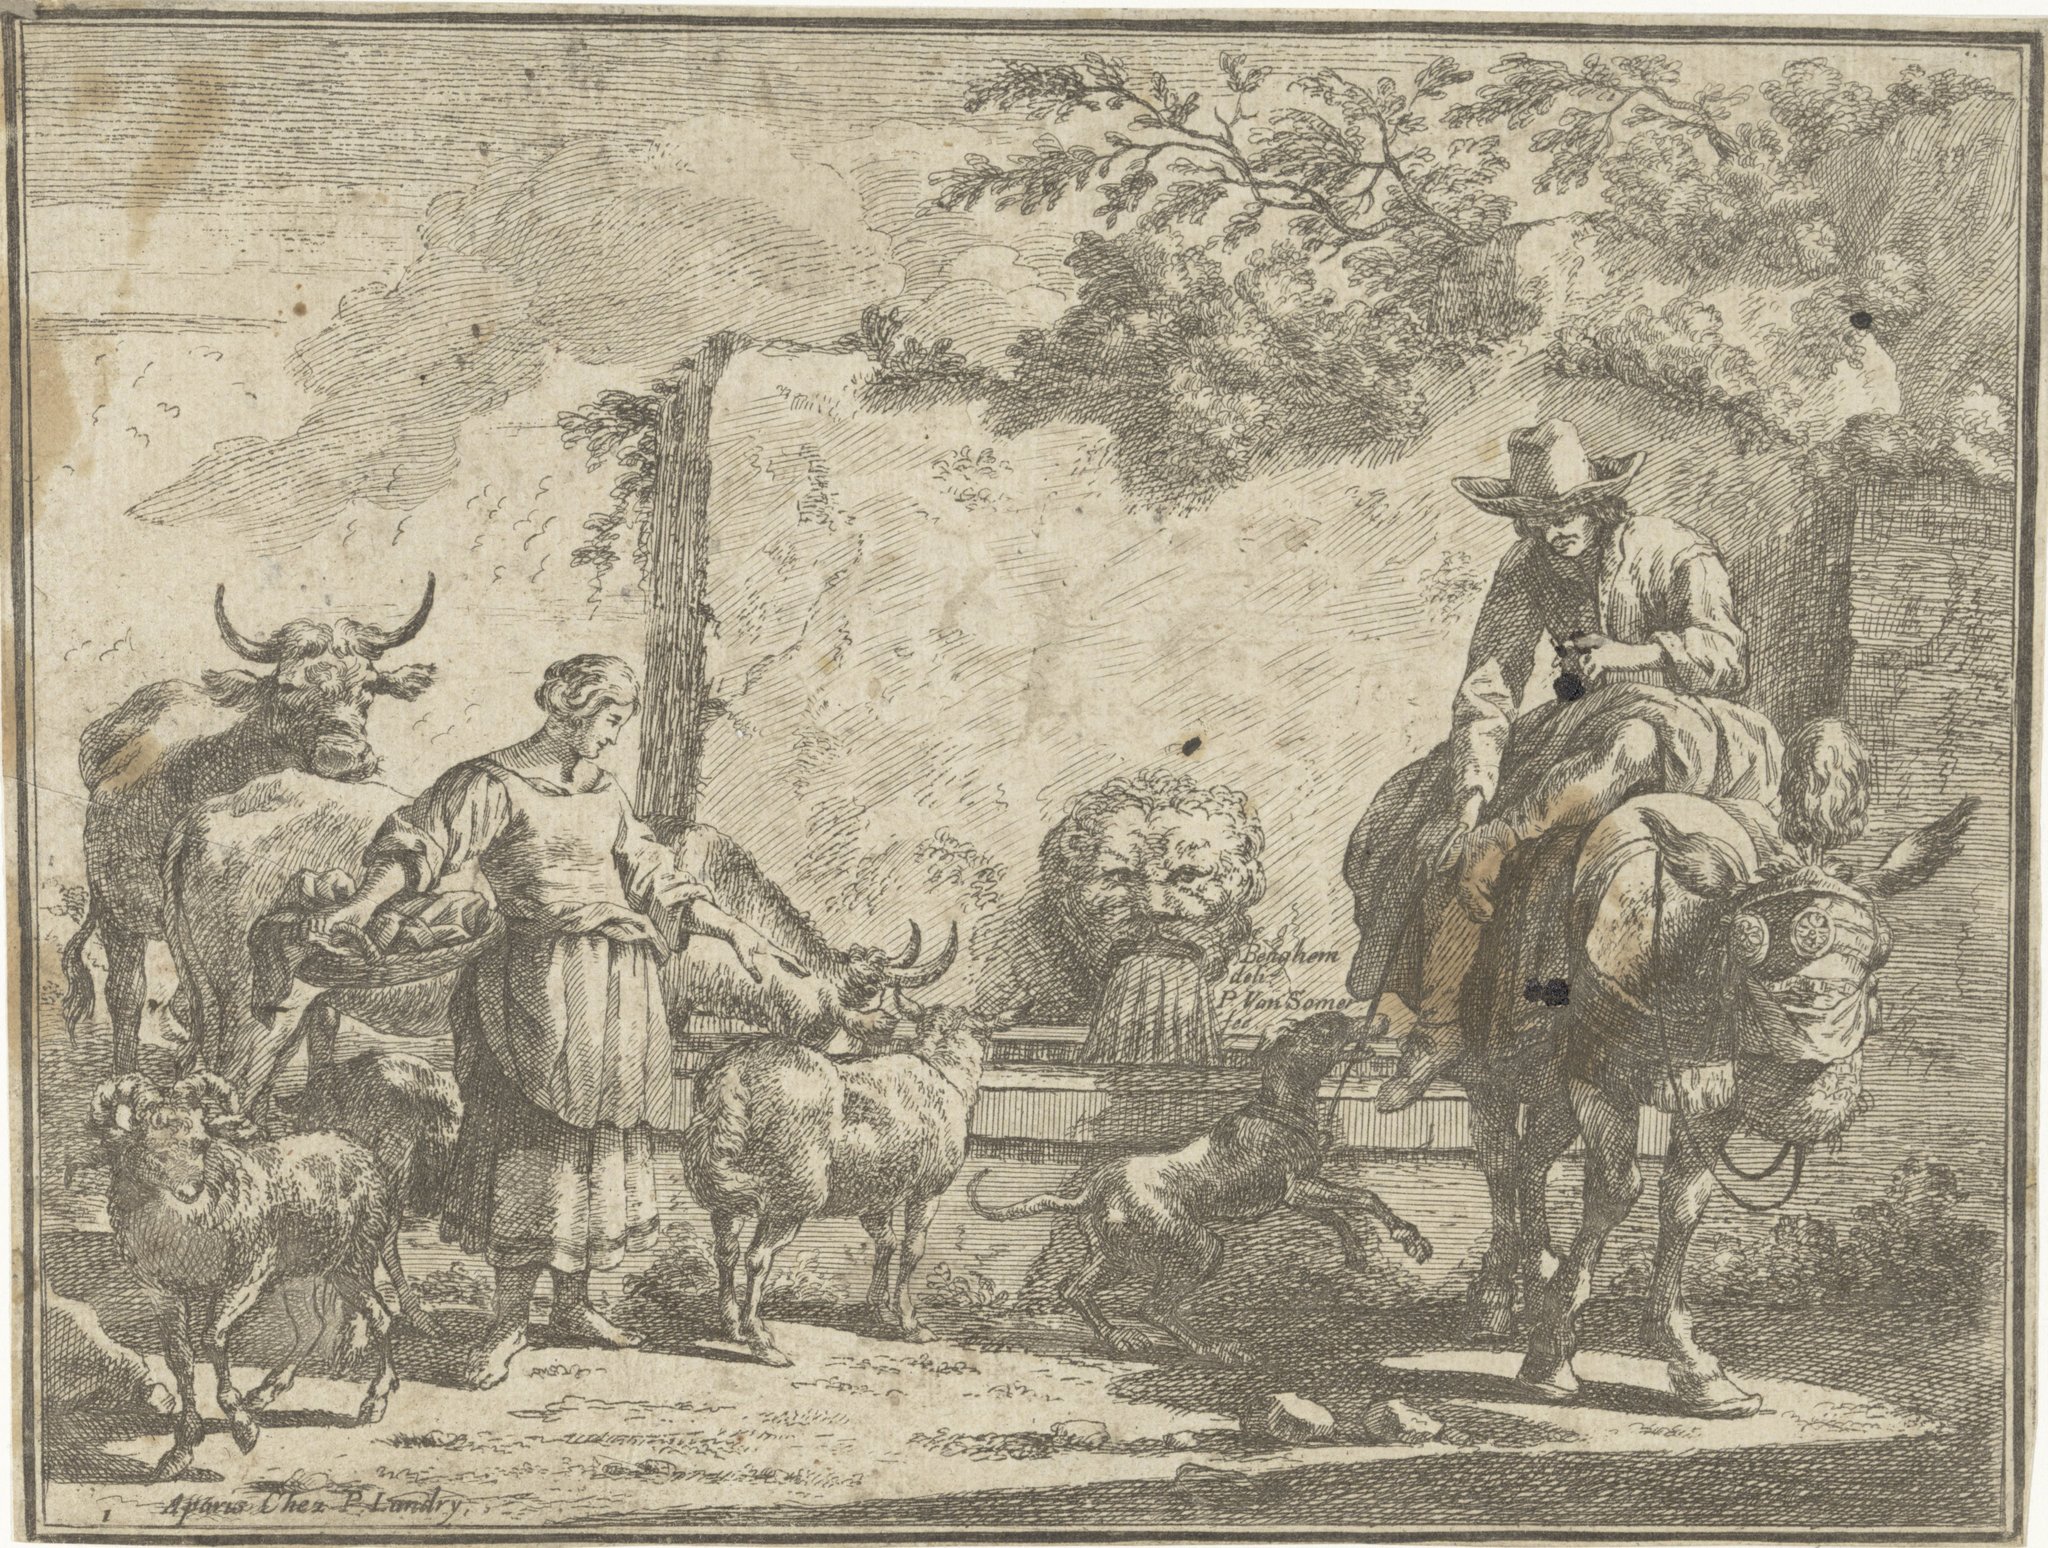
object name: print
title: Vrouw en een man op een ezel bij een waterbron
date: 1670-1675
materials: paper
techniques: etching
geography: paris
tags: ornamental fountain (in village) - ii - ideal landscapes, ass, donkey, herd, flock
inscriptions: collector's mark: Lugt 2228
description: Een vrouw met een mand met wasgoed staat bij een waterbron, waar schapen en koeien staan te drinken. Ernaast staat een man op een ezel, die een springende hond aan de lijn heeft. Hij probeert het beest tot de orde te roepen.